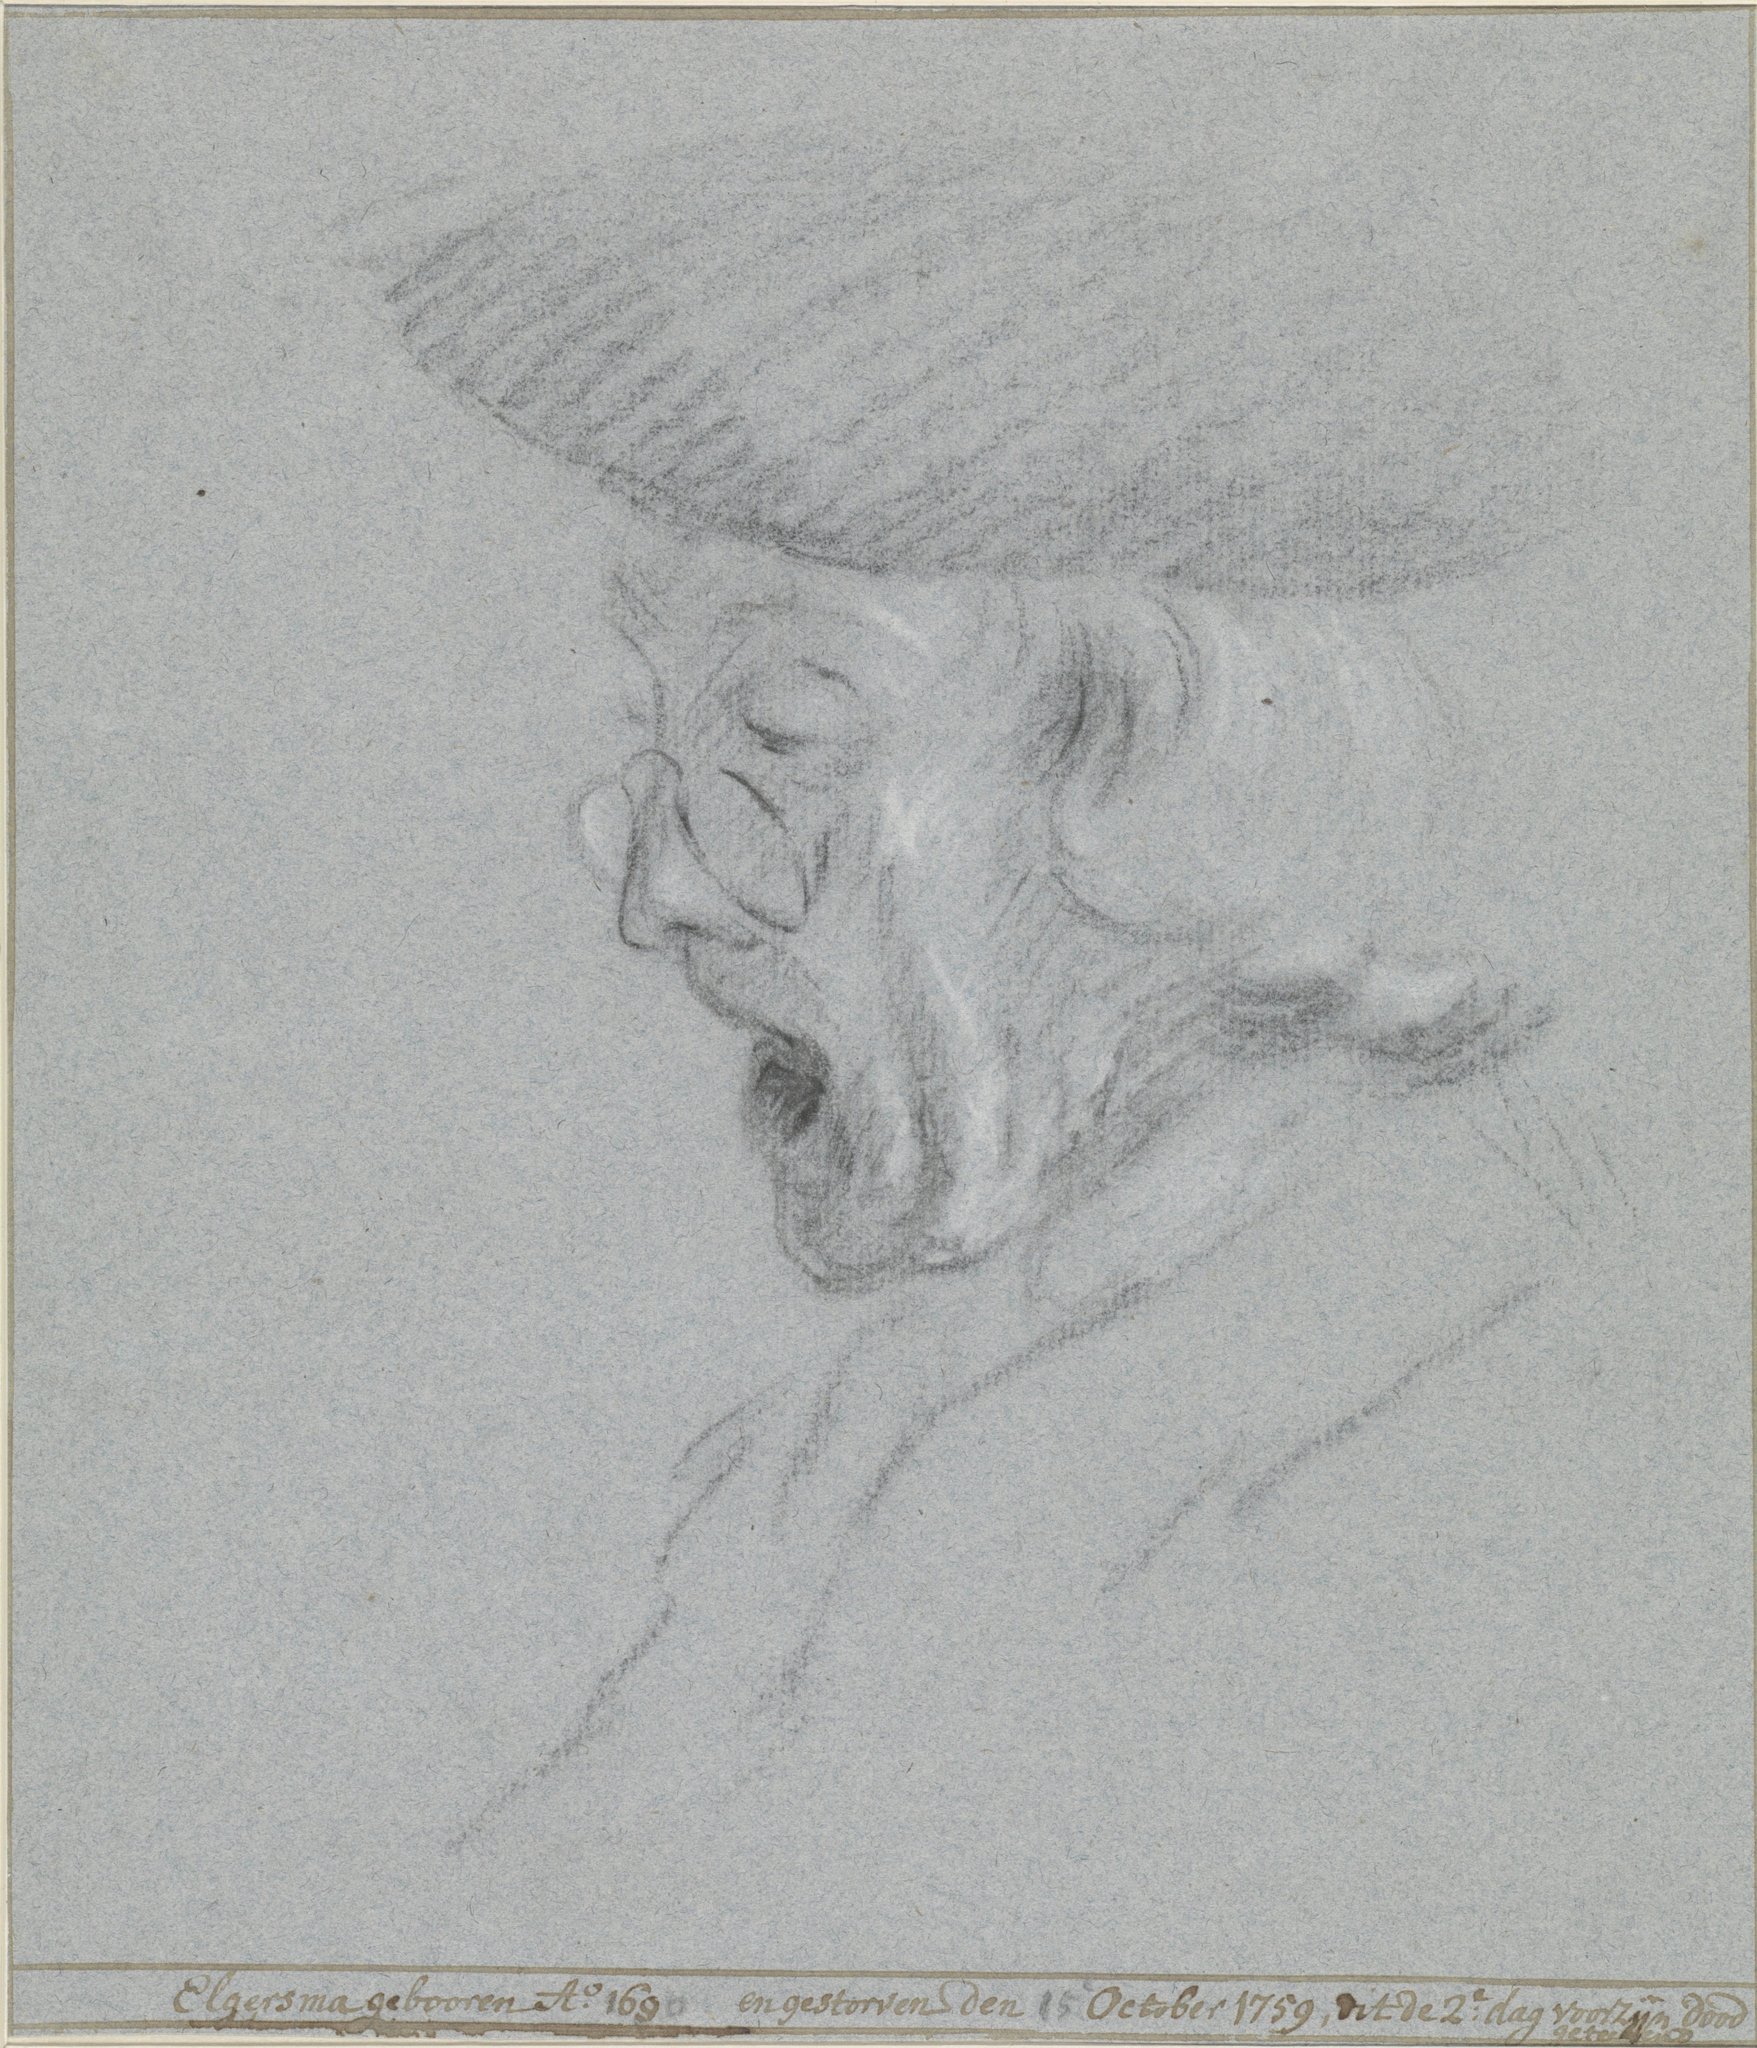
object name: drawing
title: Portret van Michiel Elgersma, met bril en mond wijd open.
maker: john greenwood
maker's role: auctioneer, draughtsman, print maker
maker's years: 1727-1792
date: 1759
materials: chalk, paper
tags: amsterdam, print maker, michiel elgersma, historical persons, portrait, self-portrait of painter, portrait, self-portrait of artist, portrait, self-portrait of draughtsman